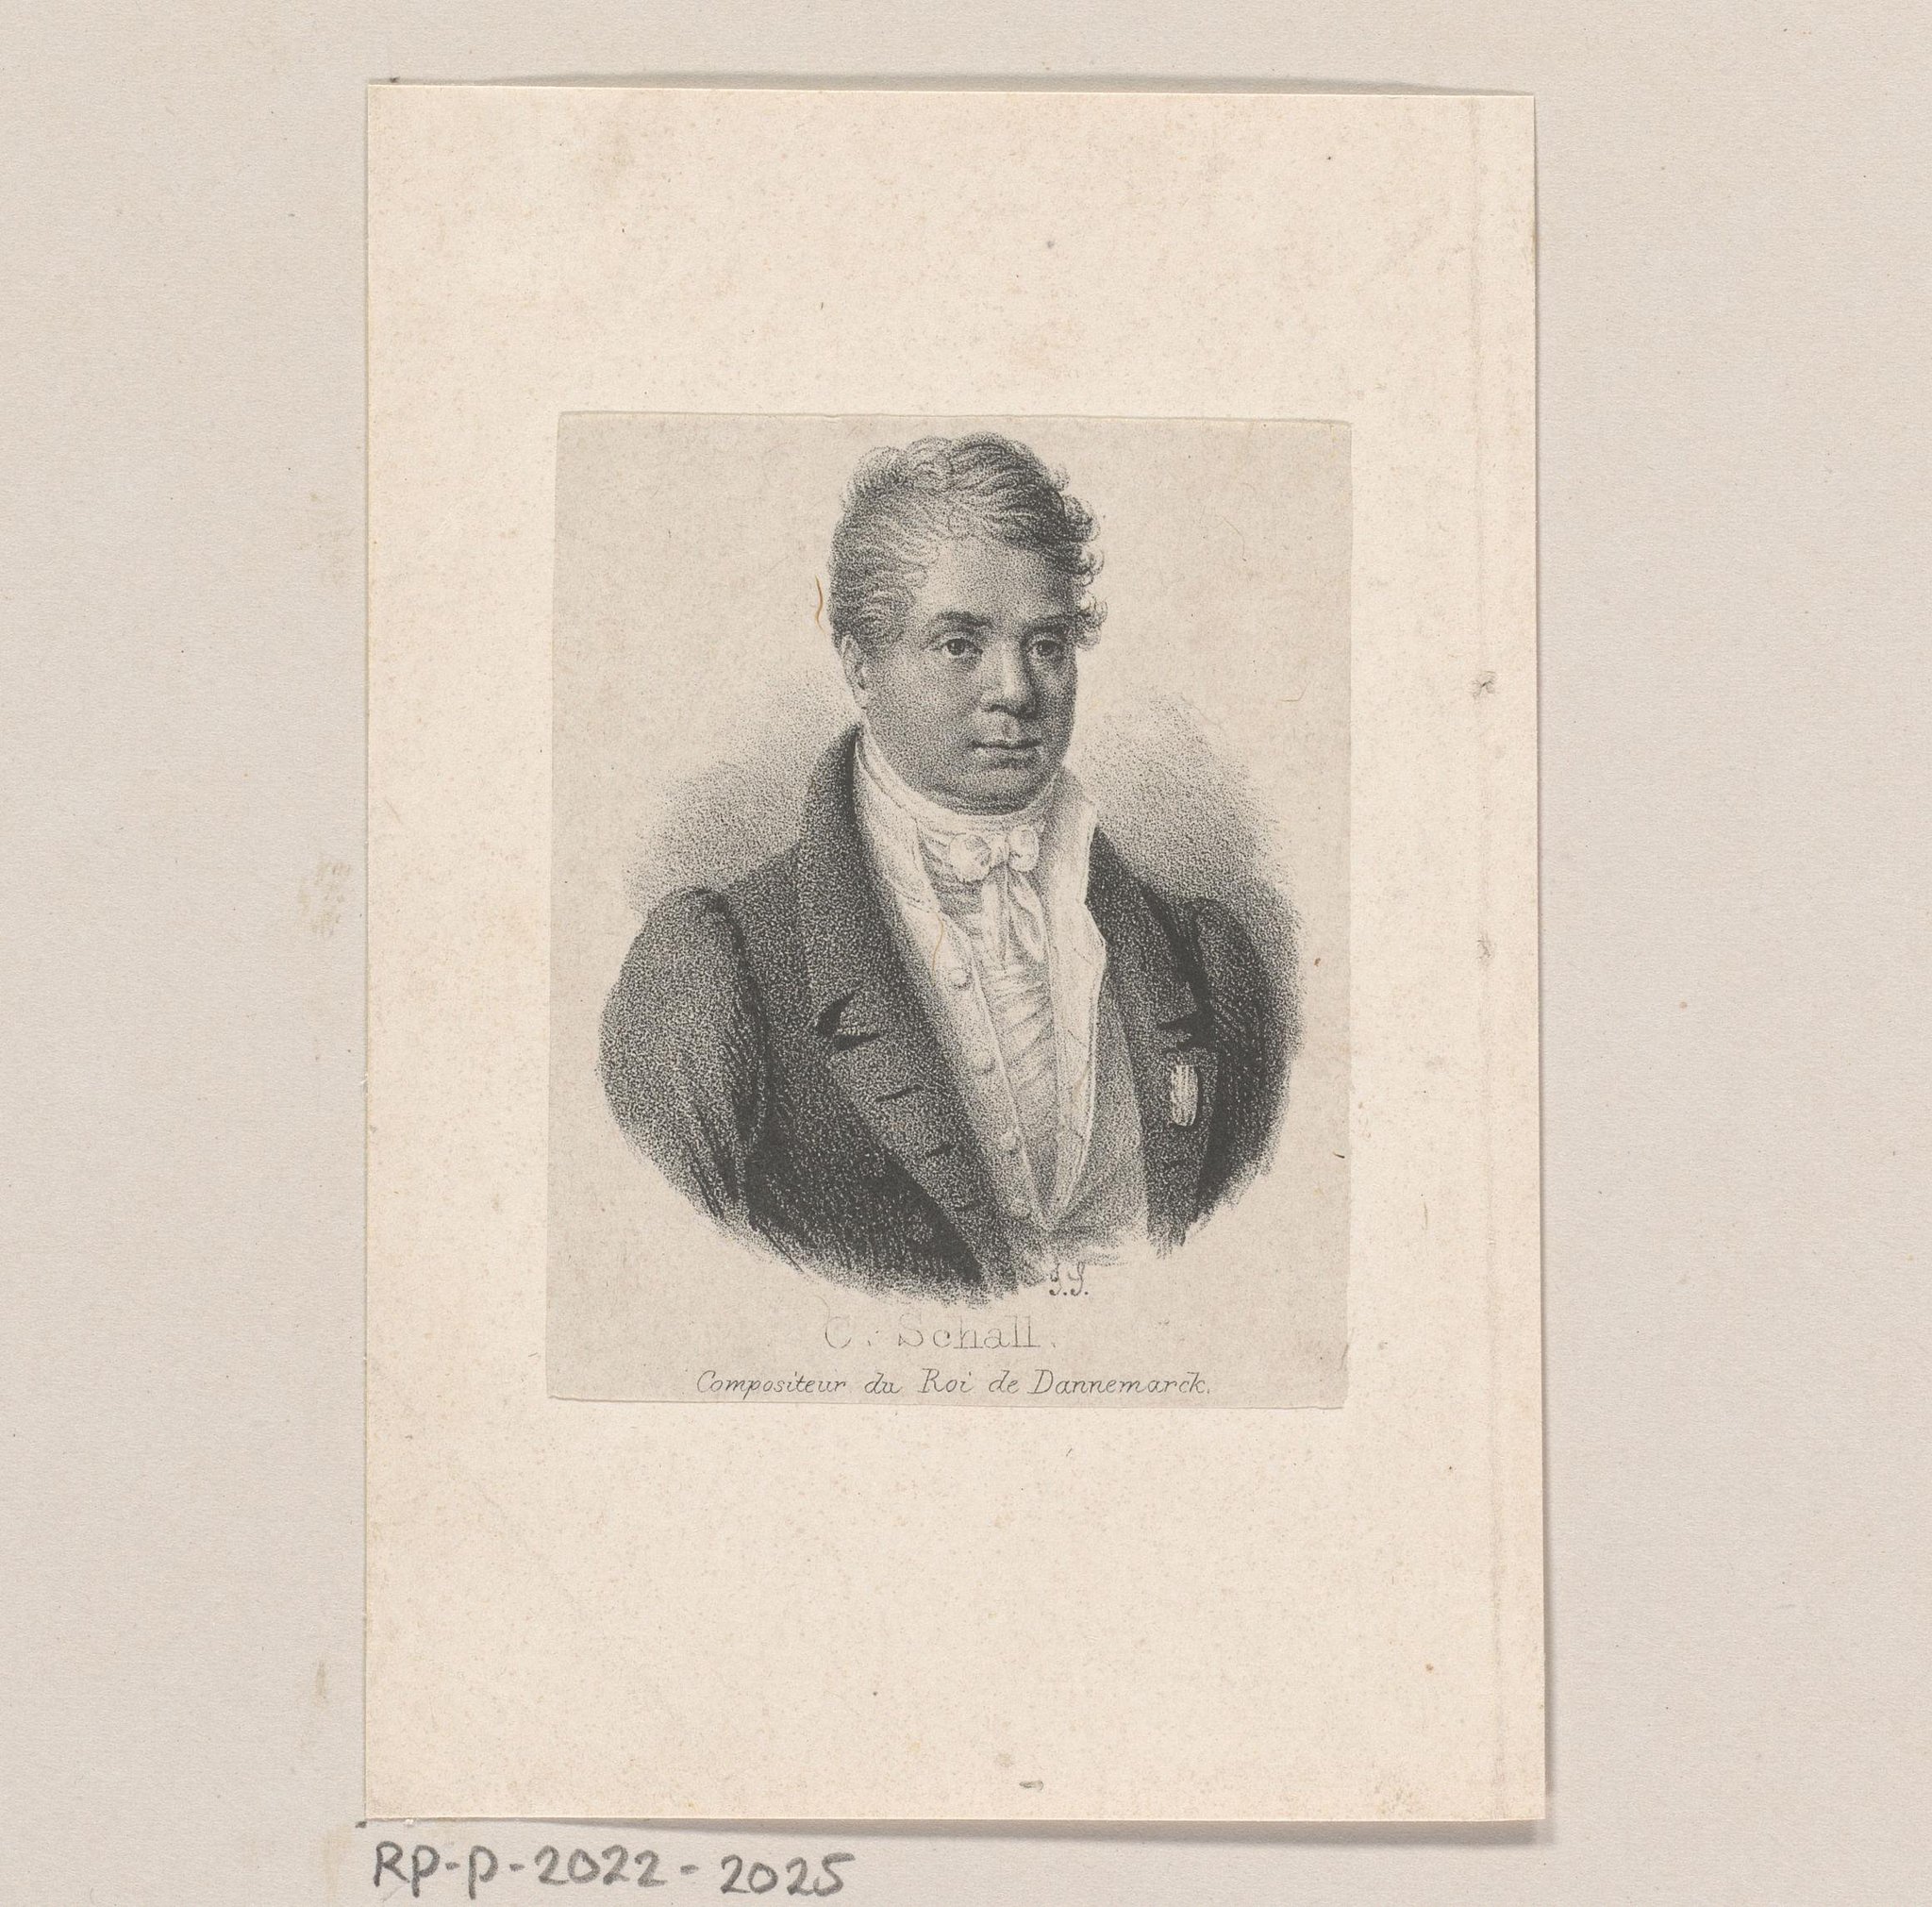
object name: print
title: Portret van Claus Schall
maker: Anonymous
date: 1778-1850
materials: paper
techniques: lithograph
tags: copenhagen (city), historical persons, composer at work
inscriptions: collector's mark: Lugt 2228